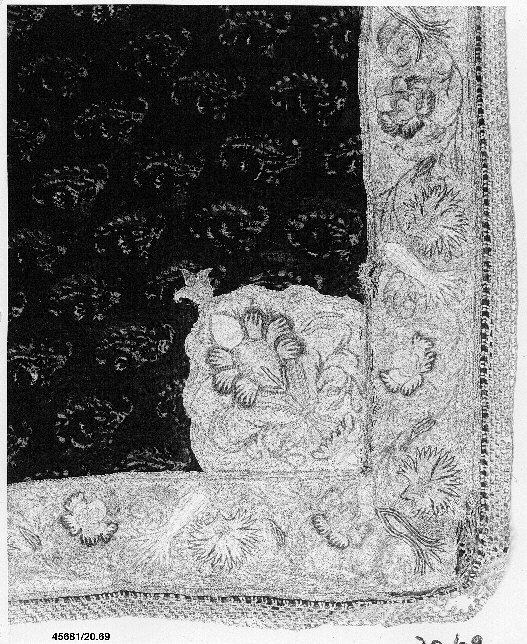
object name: veil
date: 1767-1800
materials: cotton, silk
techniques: embroidery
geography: turkey